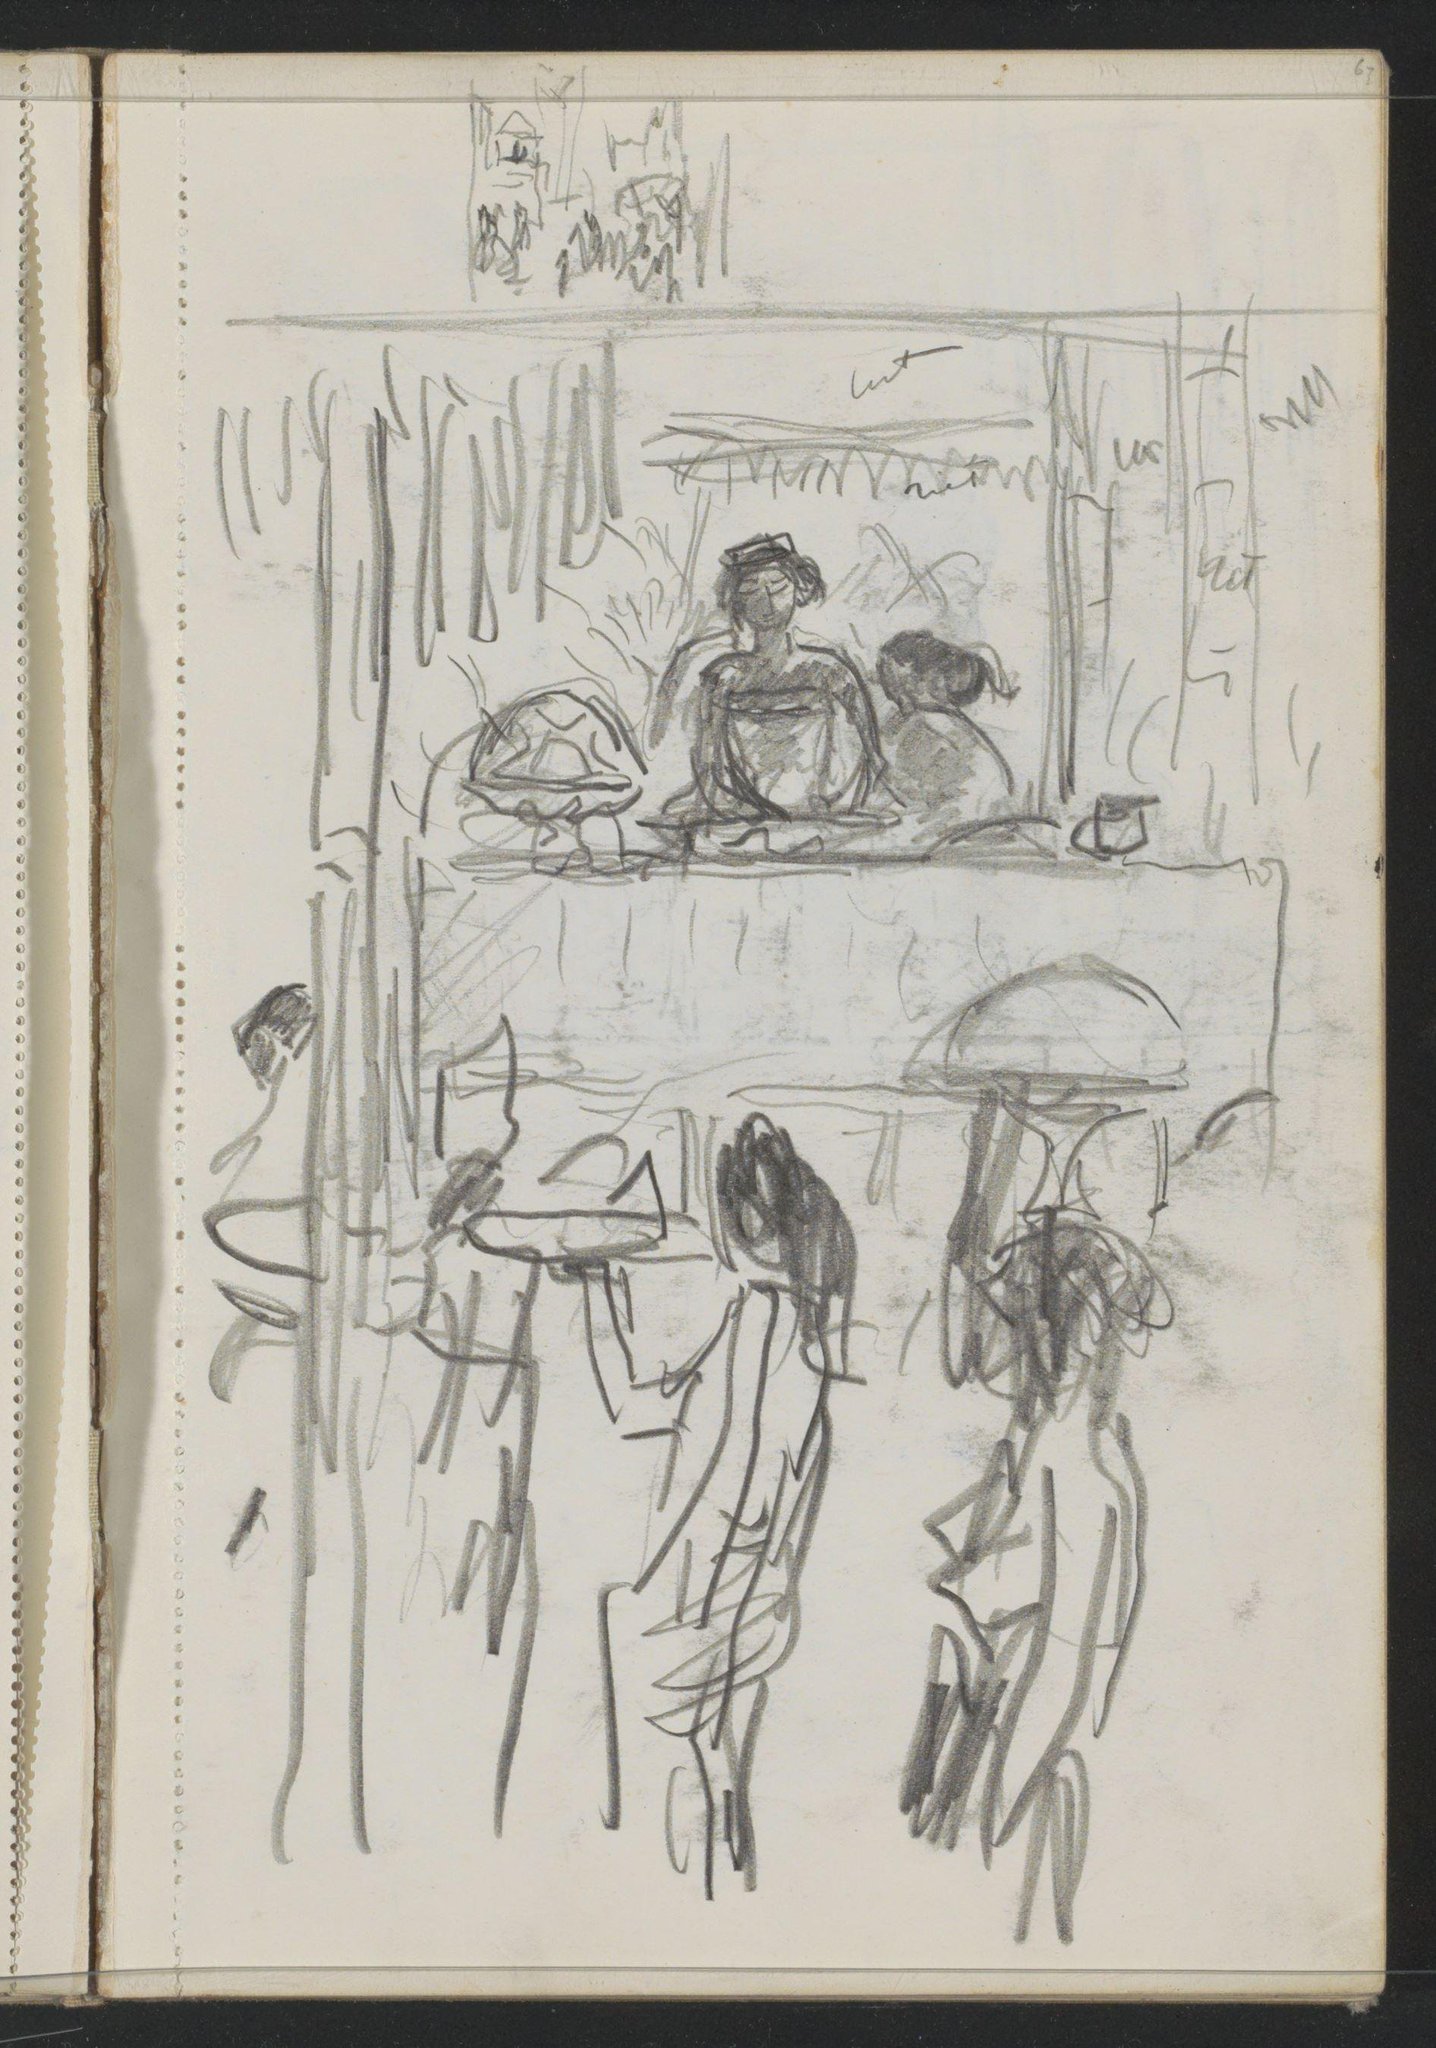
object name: sketchbook leaf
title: Figuren die offers naar een altaar brengen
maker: marius bauer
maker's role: draughtsman, print maker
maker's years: 1867-1932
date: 1925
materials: paper, pencil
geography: indonesia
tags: asiatic races and peoples, altar ~ hinduism, buddhism, jainism, sacrifice ~ non-christian religions, carrying something on the head or on the shoulders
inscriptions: kleurnotitie, handgeschreven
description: Pagina 67 uit een schetsboek met 74 bladen.